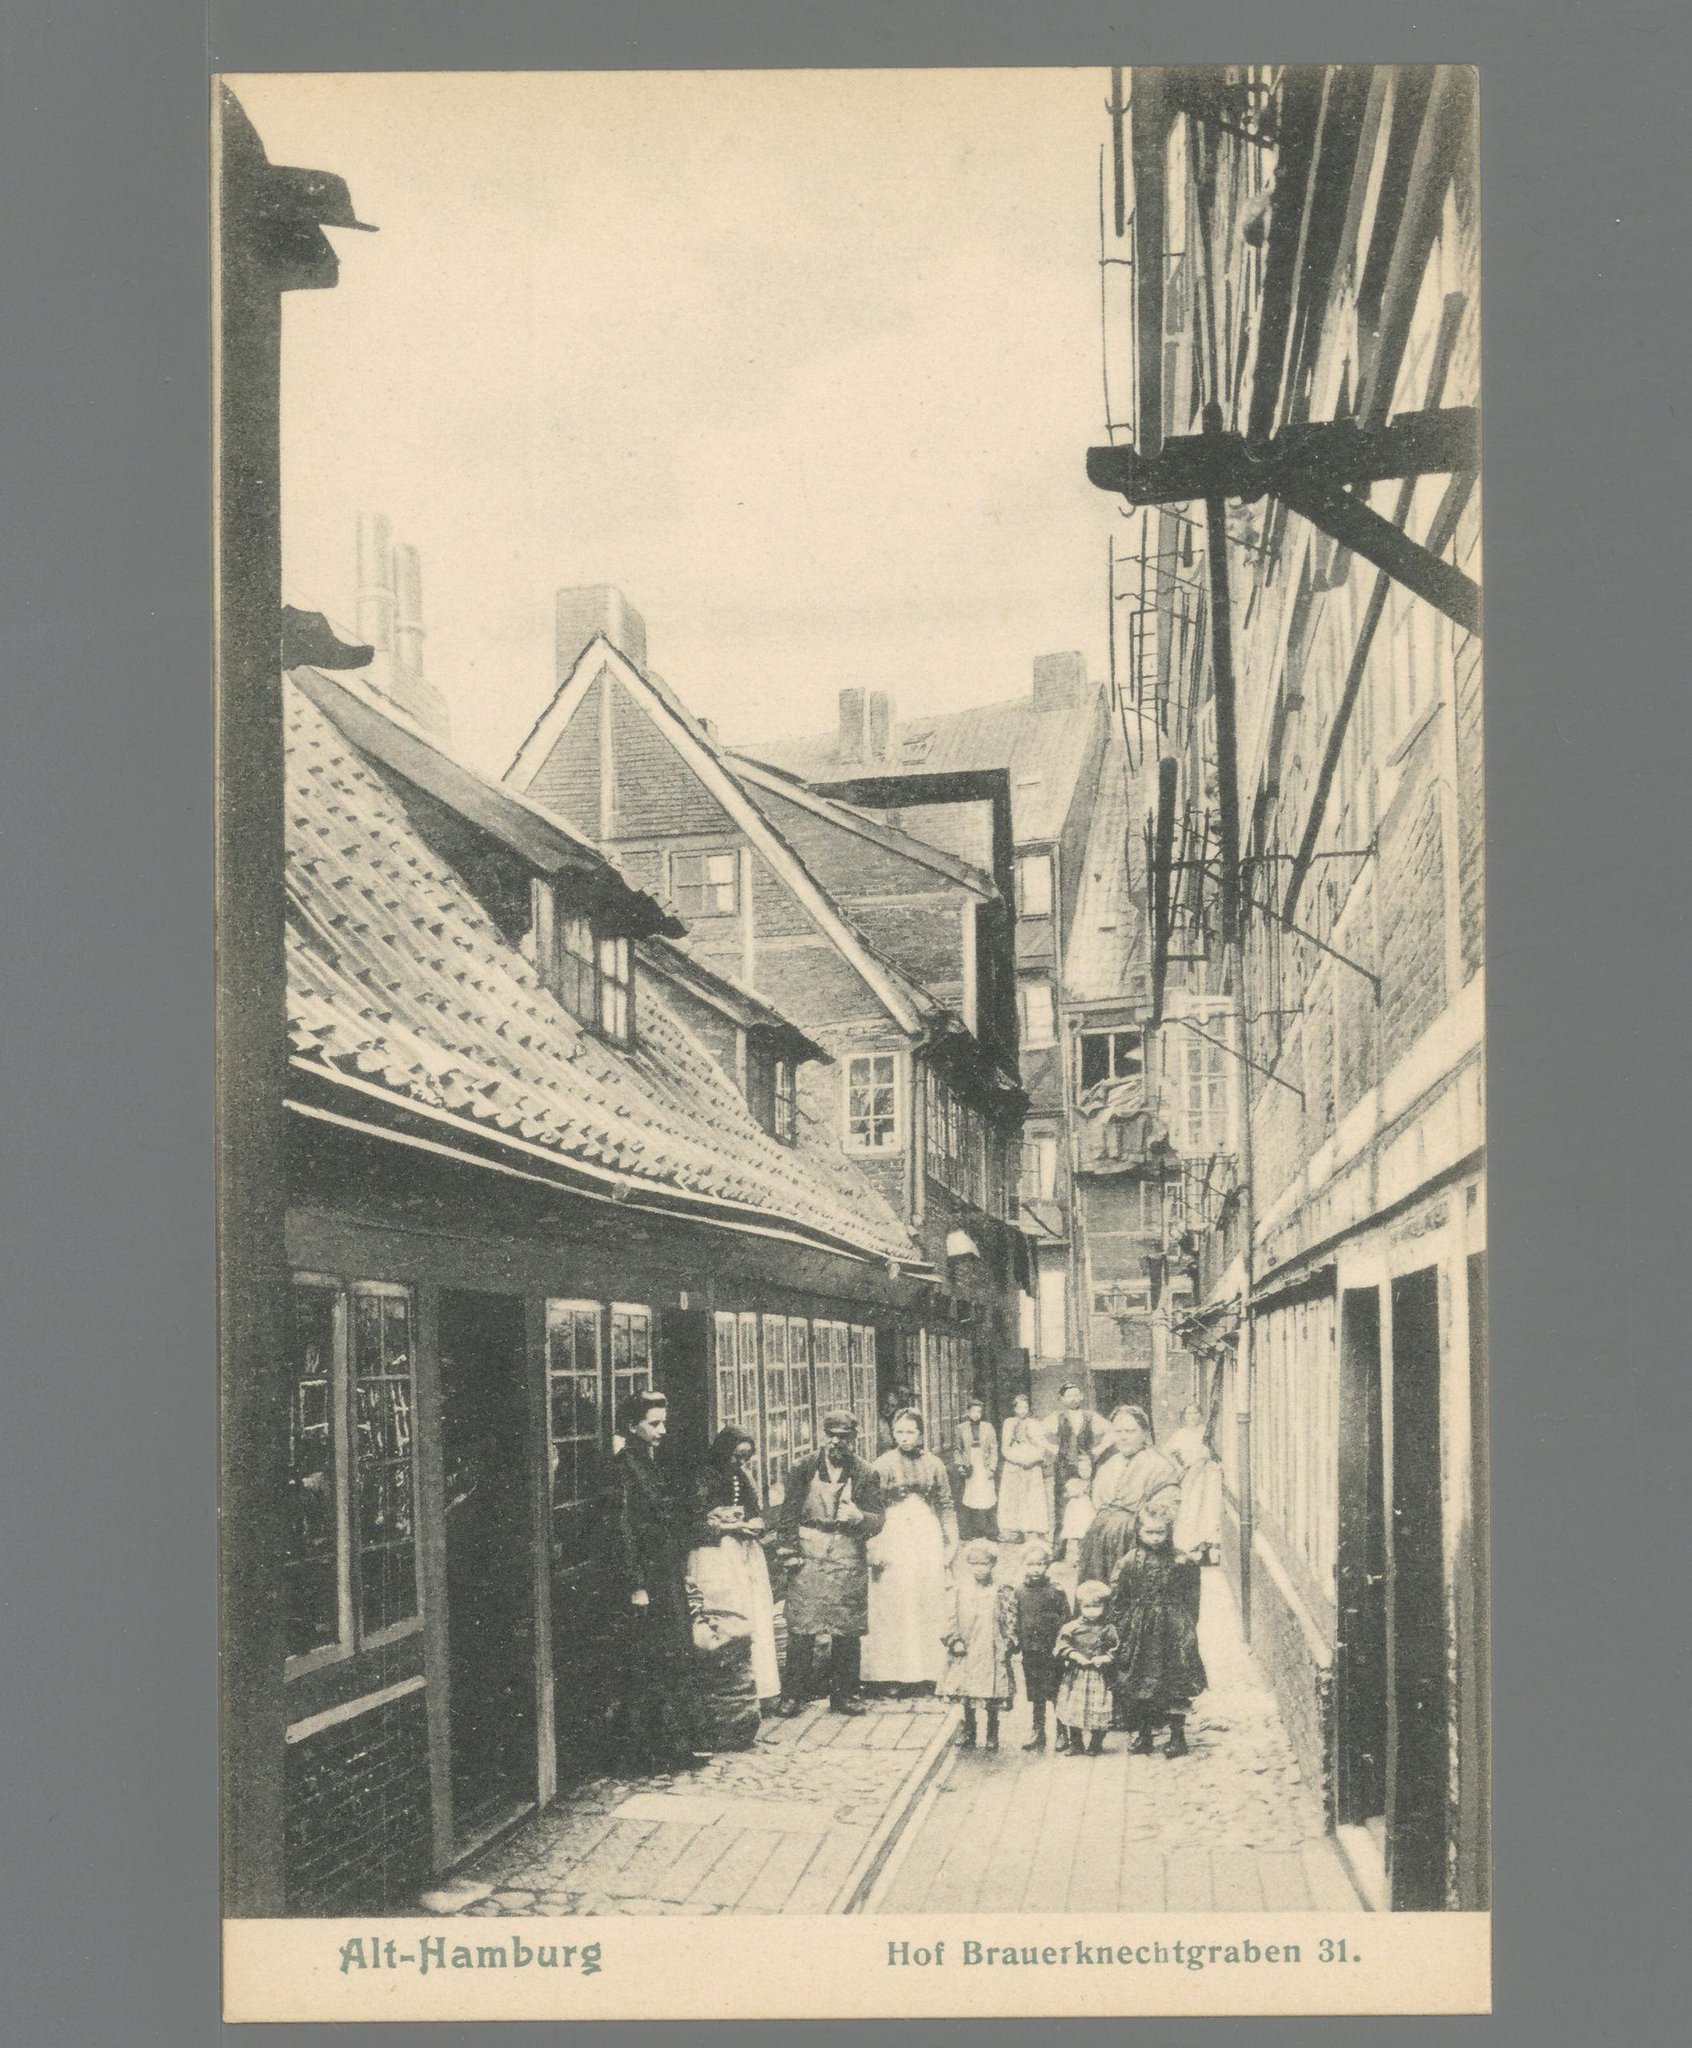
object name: ansichtkaart, prentbriefkaart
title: Alt-Hamburg. Hof Brauerknechtgraben 31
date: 1905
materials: cardboard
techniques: photograph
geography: hamburg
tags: street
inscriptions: date